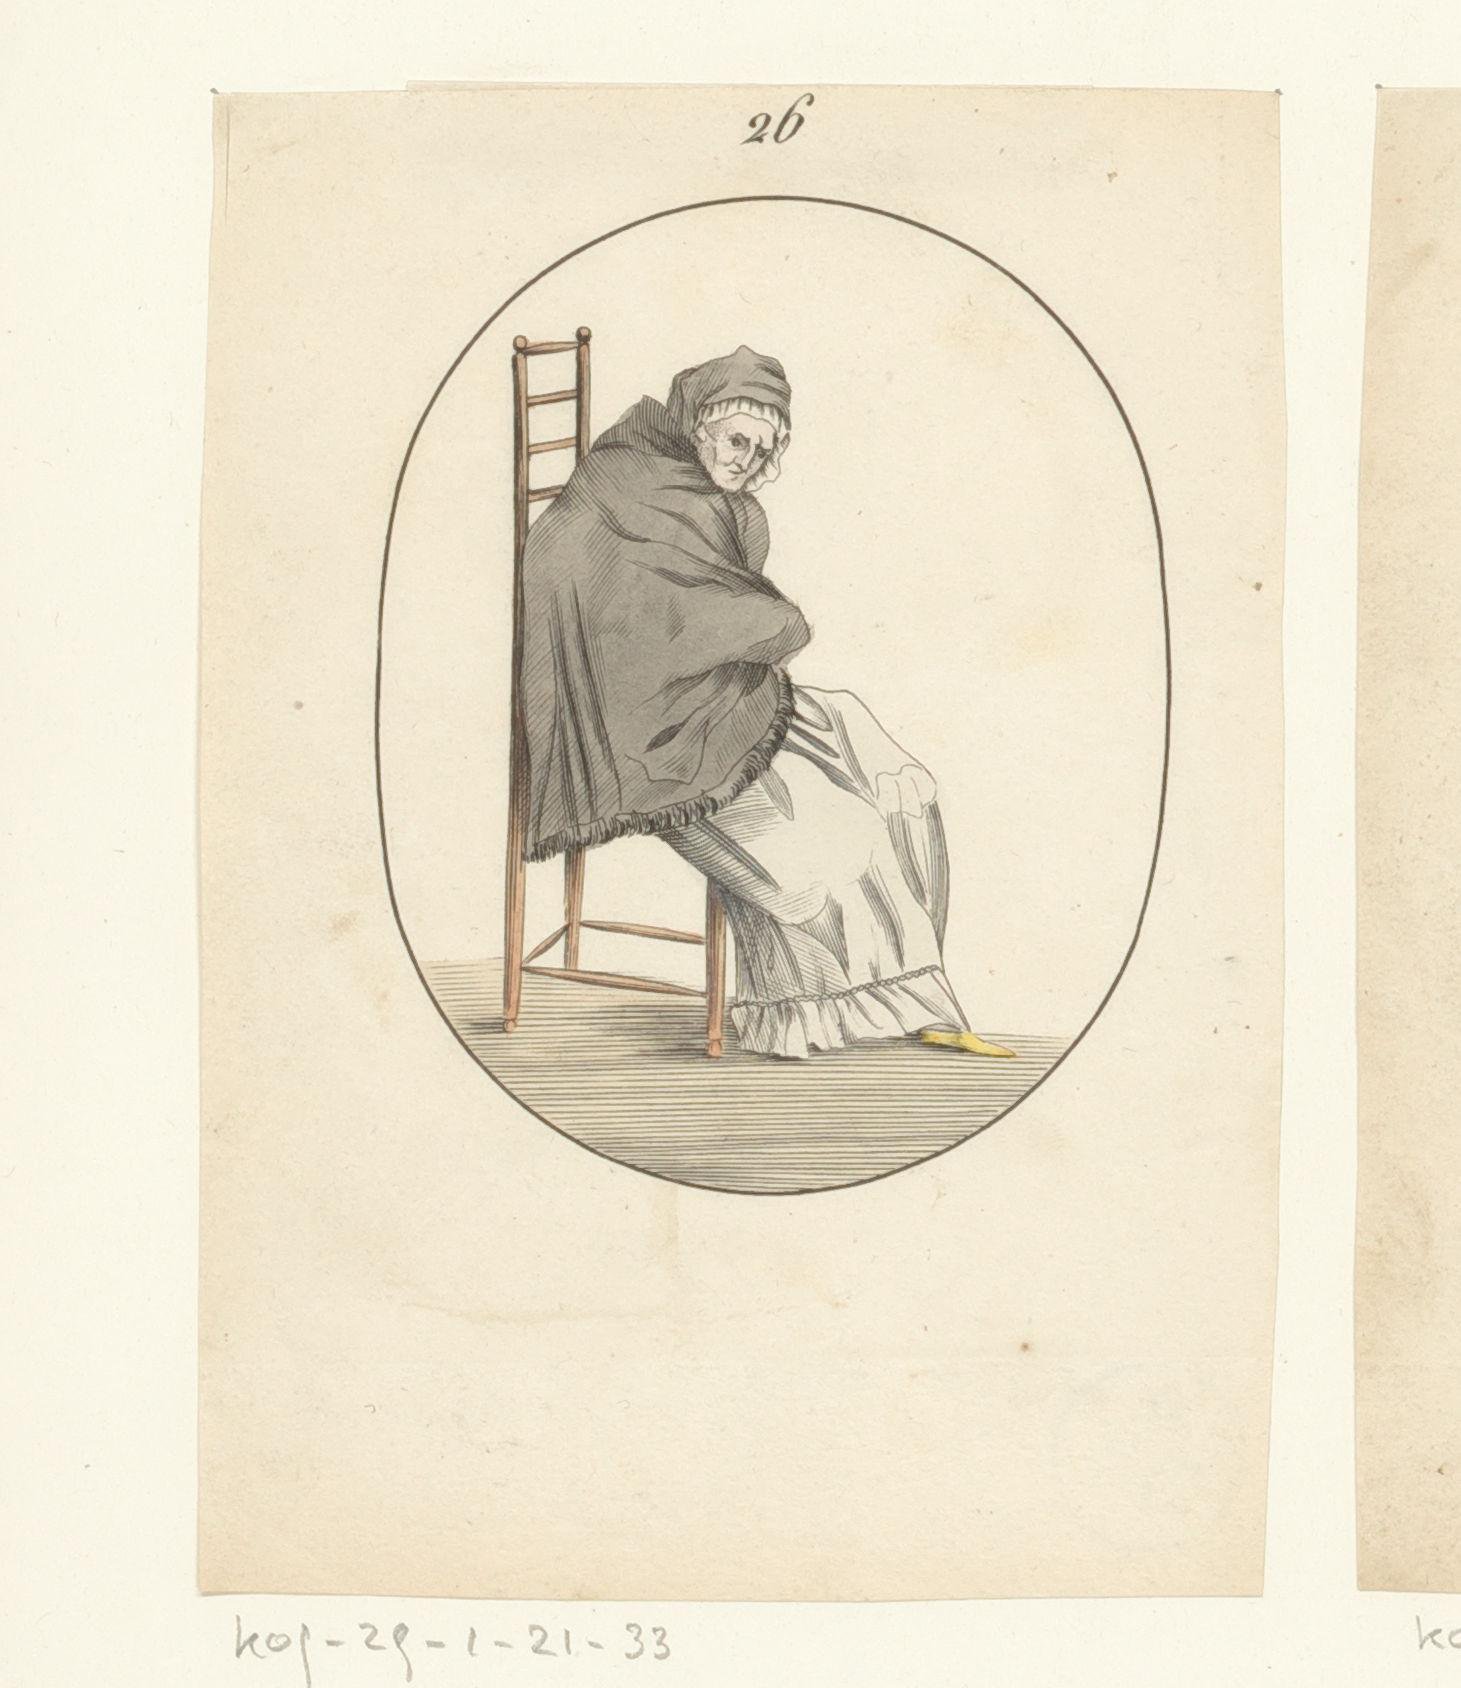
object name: print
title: Zittende oude vrouw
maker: Anonymous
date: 1750-1849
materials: paper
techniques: etching, hand coloring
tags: sitting on an elevation - aa - female human figure (+ three-quarter view), old woman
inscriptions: collector's mark: Lugt 1641a, collector's mark: Lugt 1641, stamp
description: Bovenaan genummerd: 26. Onderwerpsrubrieken binnen de Atlas Zeden en Gewoonten: Zeden en Gewoonten in Engeren Zin, De Kleeding, Kleederdrachten (tijdvakken), De 18de eeuw (de pruikentijd). Mannen en vrouwen.